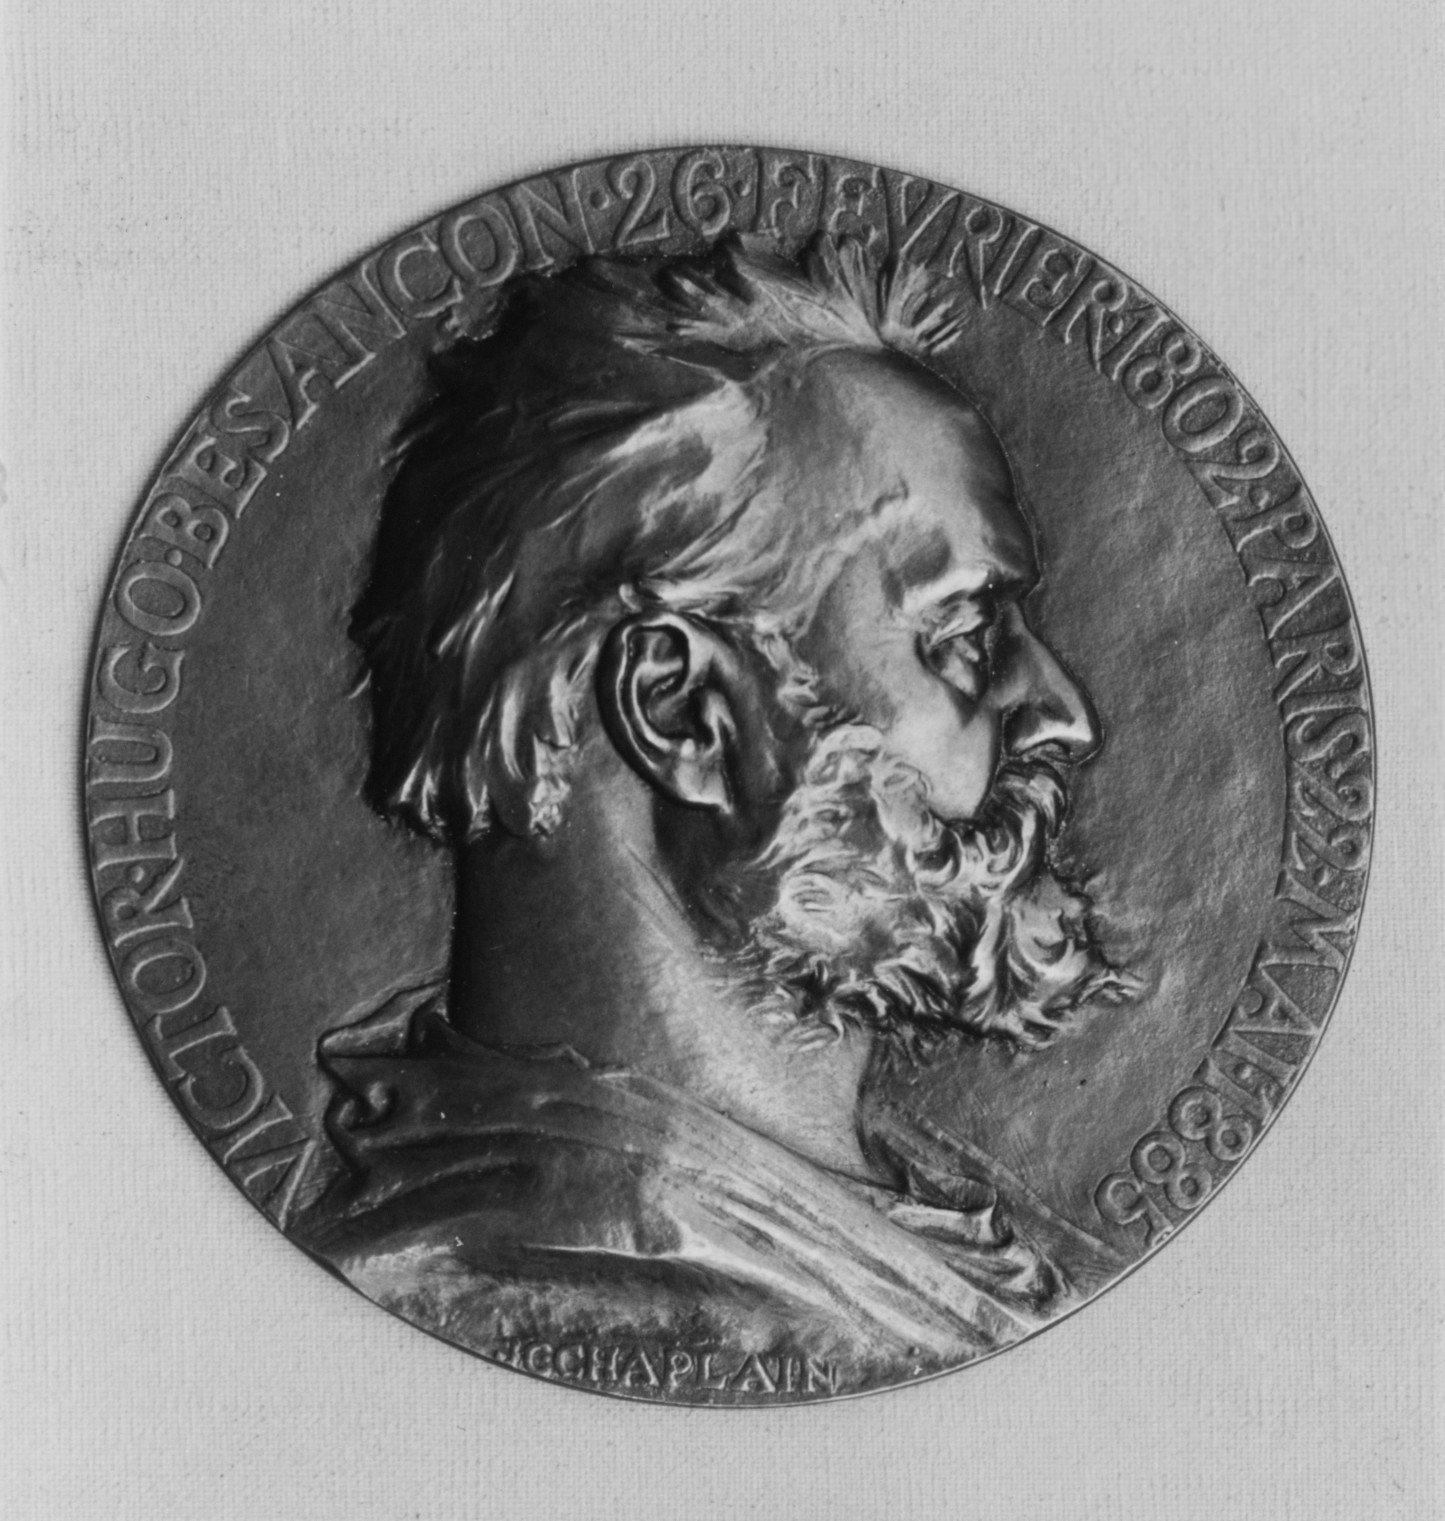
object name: medallion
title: In Honor of Victor Hugo, Novelist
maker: jules-clément chaplain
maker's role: artist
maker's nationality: french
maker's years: 1839-1909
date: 1885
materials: bronze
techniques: casting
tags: men,profiles